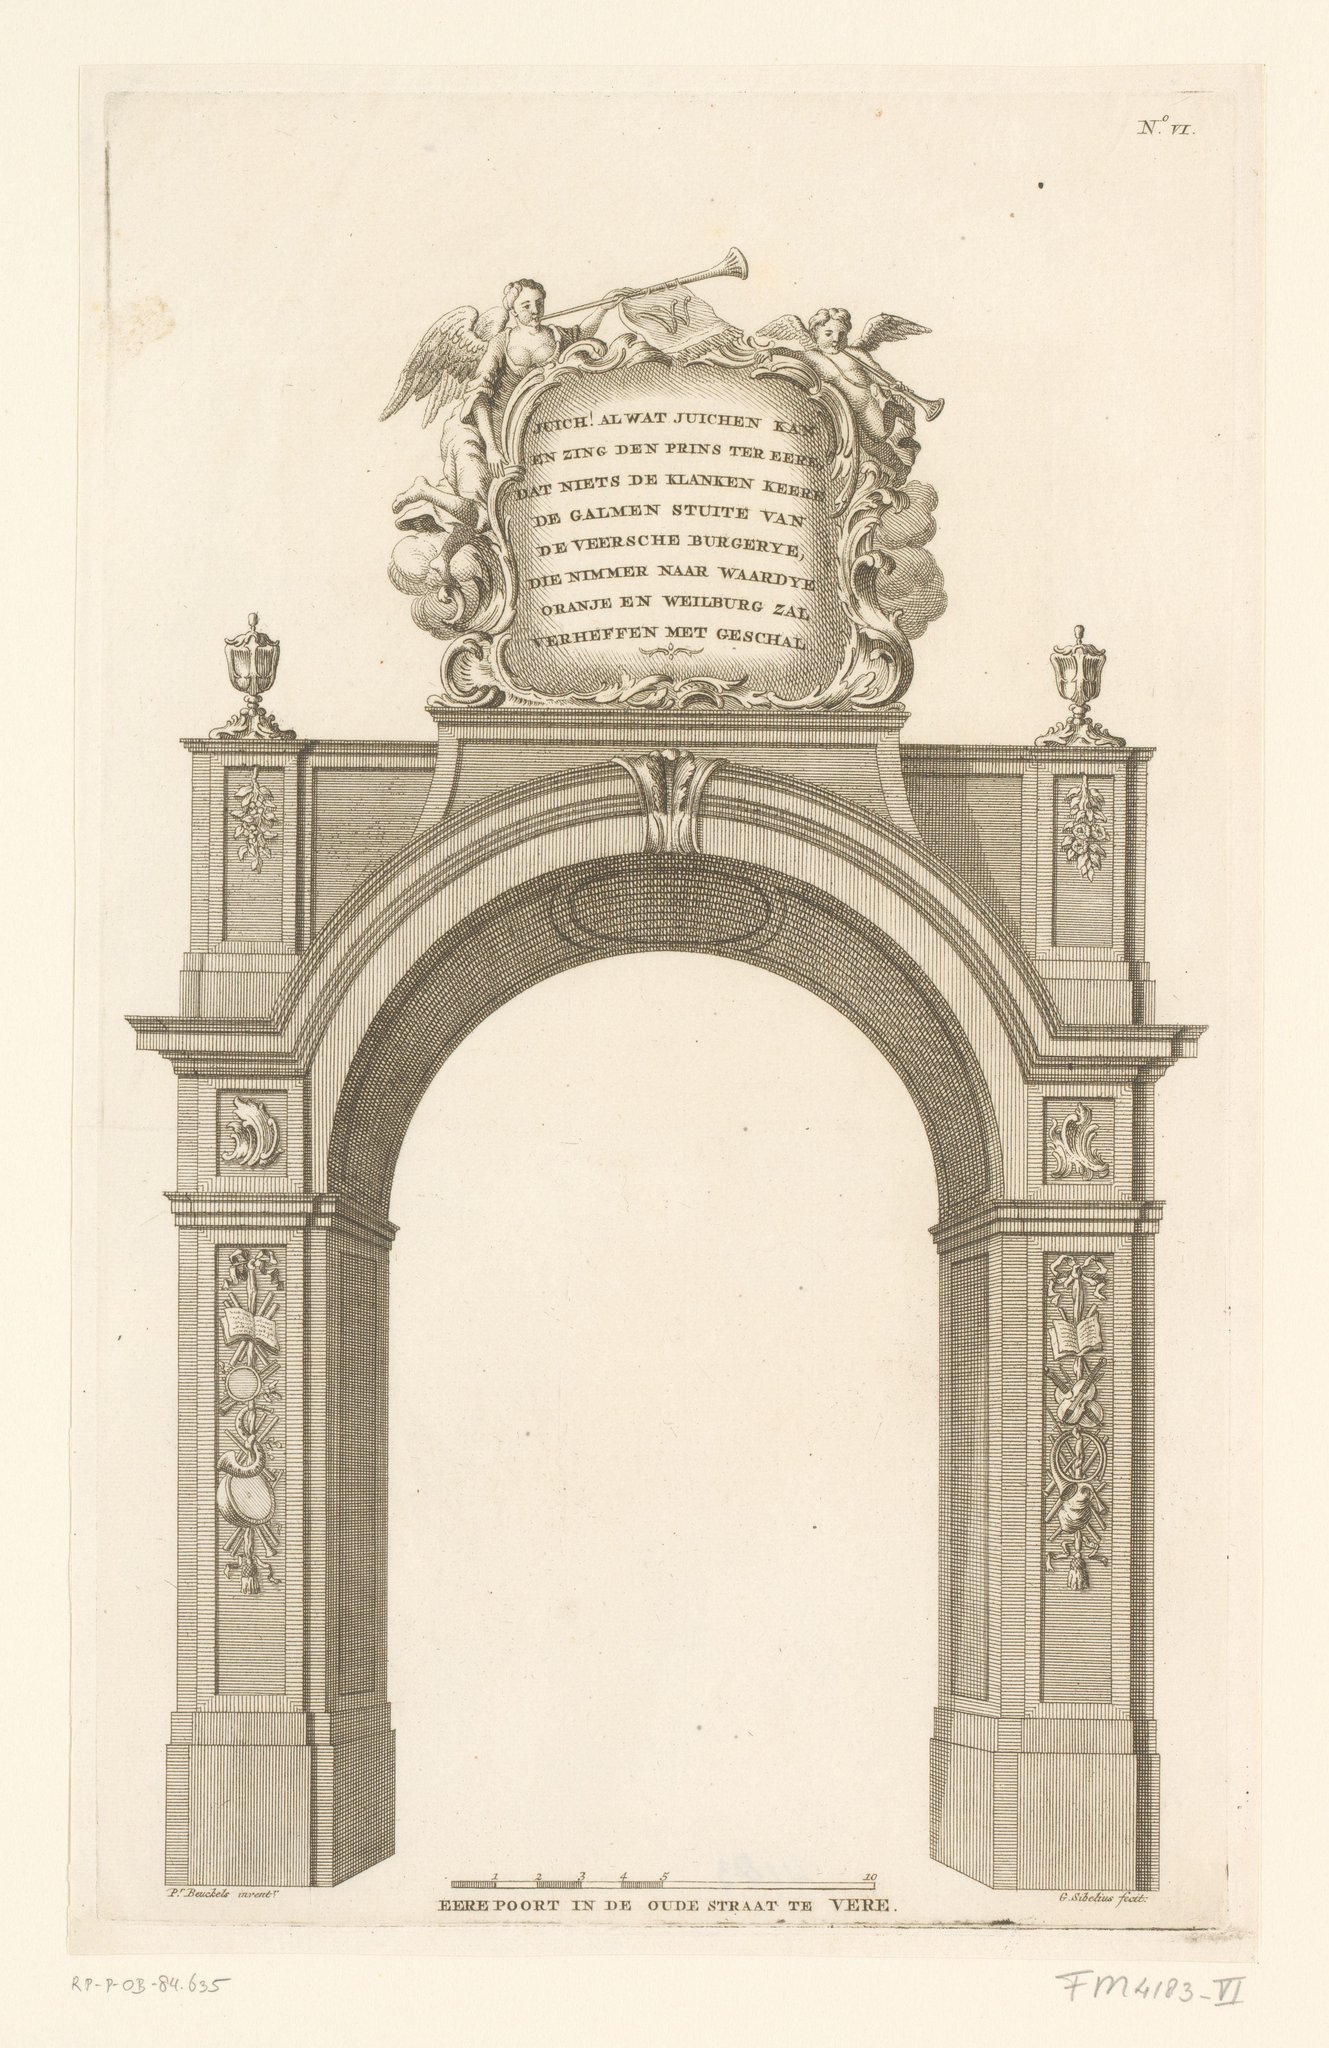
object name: print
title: Erepoorten bij de intocht van Willem V te Veere (Nr. VI), 1766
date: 1766-1767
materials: paper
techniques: engraving, etching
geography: northern netherlands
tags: william v (prince of orange), triumphal arch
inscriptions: collector's mark: Lugt 2228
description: De erepoort opgericht in de Oudestraat te Veere. Bovenin een cartouche met een vers. Onderdeel van een groep van 10 platen van de decoraties te Veere ter gelegenheid van de inhuldiging van stadhouder Willem V als Markgraaf van Veere, 28 mei 1766. Genummerd rechtsboven: No. VI.